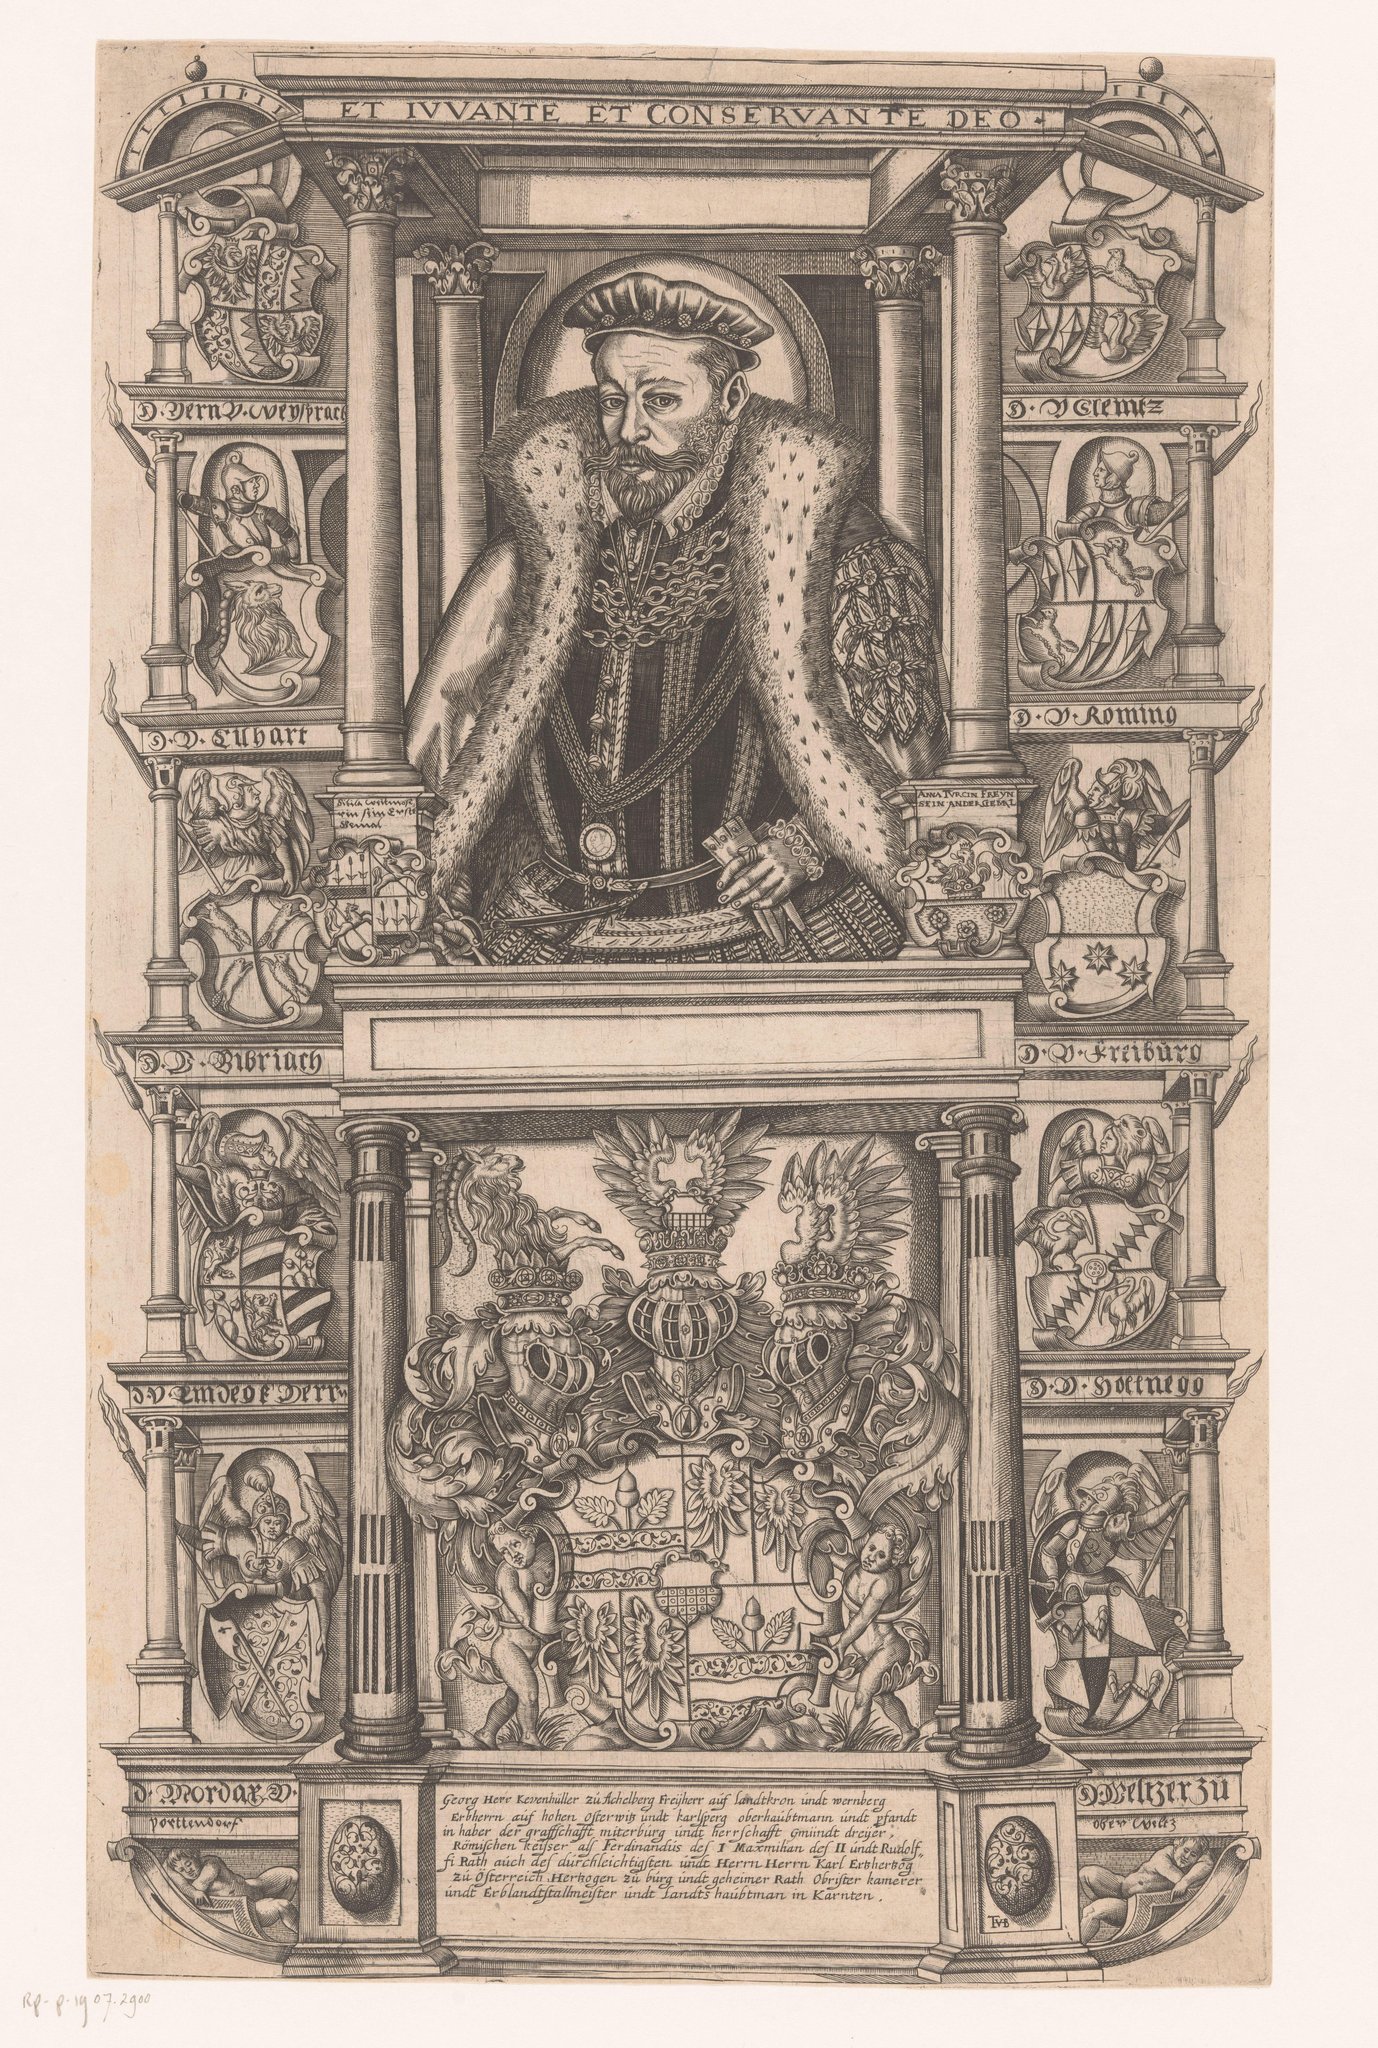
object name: print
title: Portret van Georg von Khevenhüller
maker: monogrammist tvb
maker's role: print maker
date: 1560-1580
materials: paper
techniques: engraving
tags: historical persons, armorial bearing, heraldry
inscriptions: collector's mark: Lugt 2228